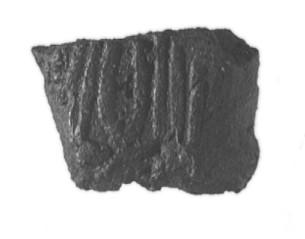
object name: sealing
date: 2030-1640 BCE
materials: clay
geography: egypt